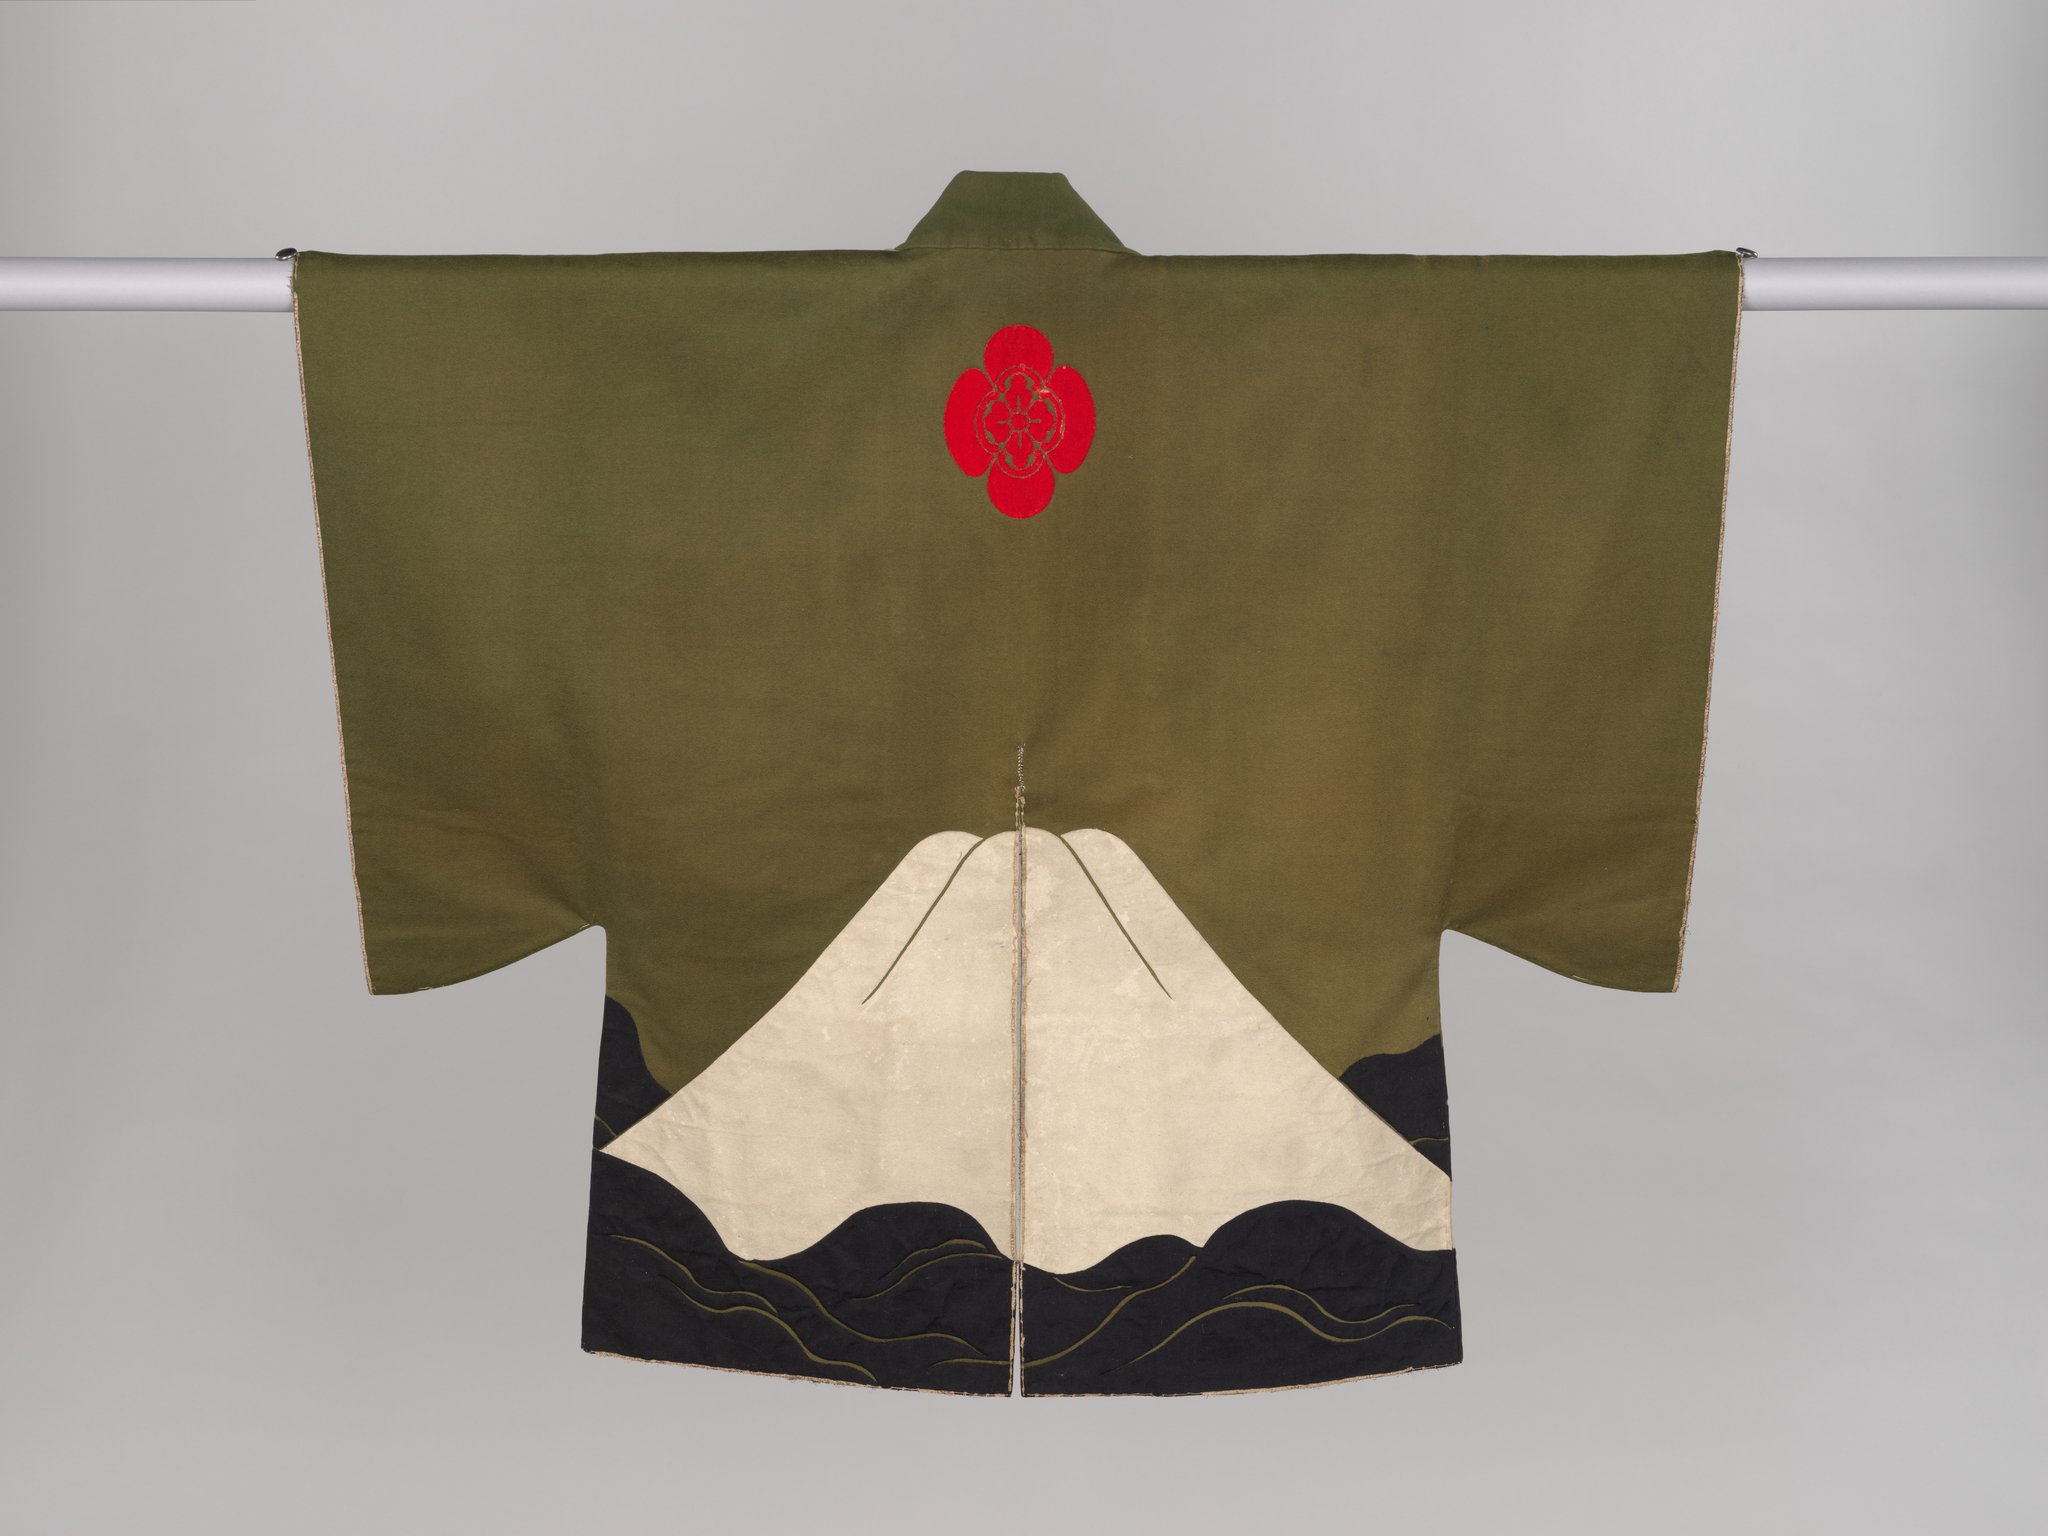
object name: battle surcoat jinbaori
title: Battle surcoat (jinbaori) with Mount Fuji and waves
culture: japanese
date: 1801-1850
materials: silk, wool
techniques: brocade, lining